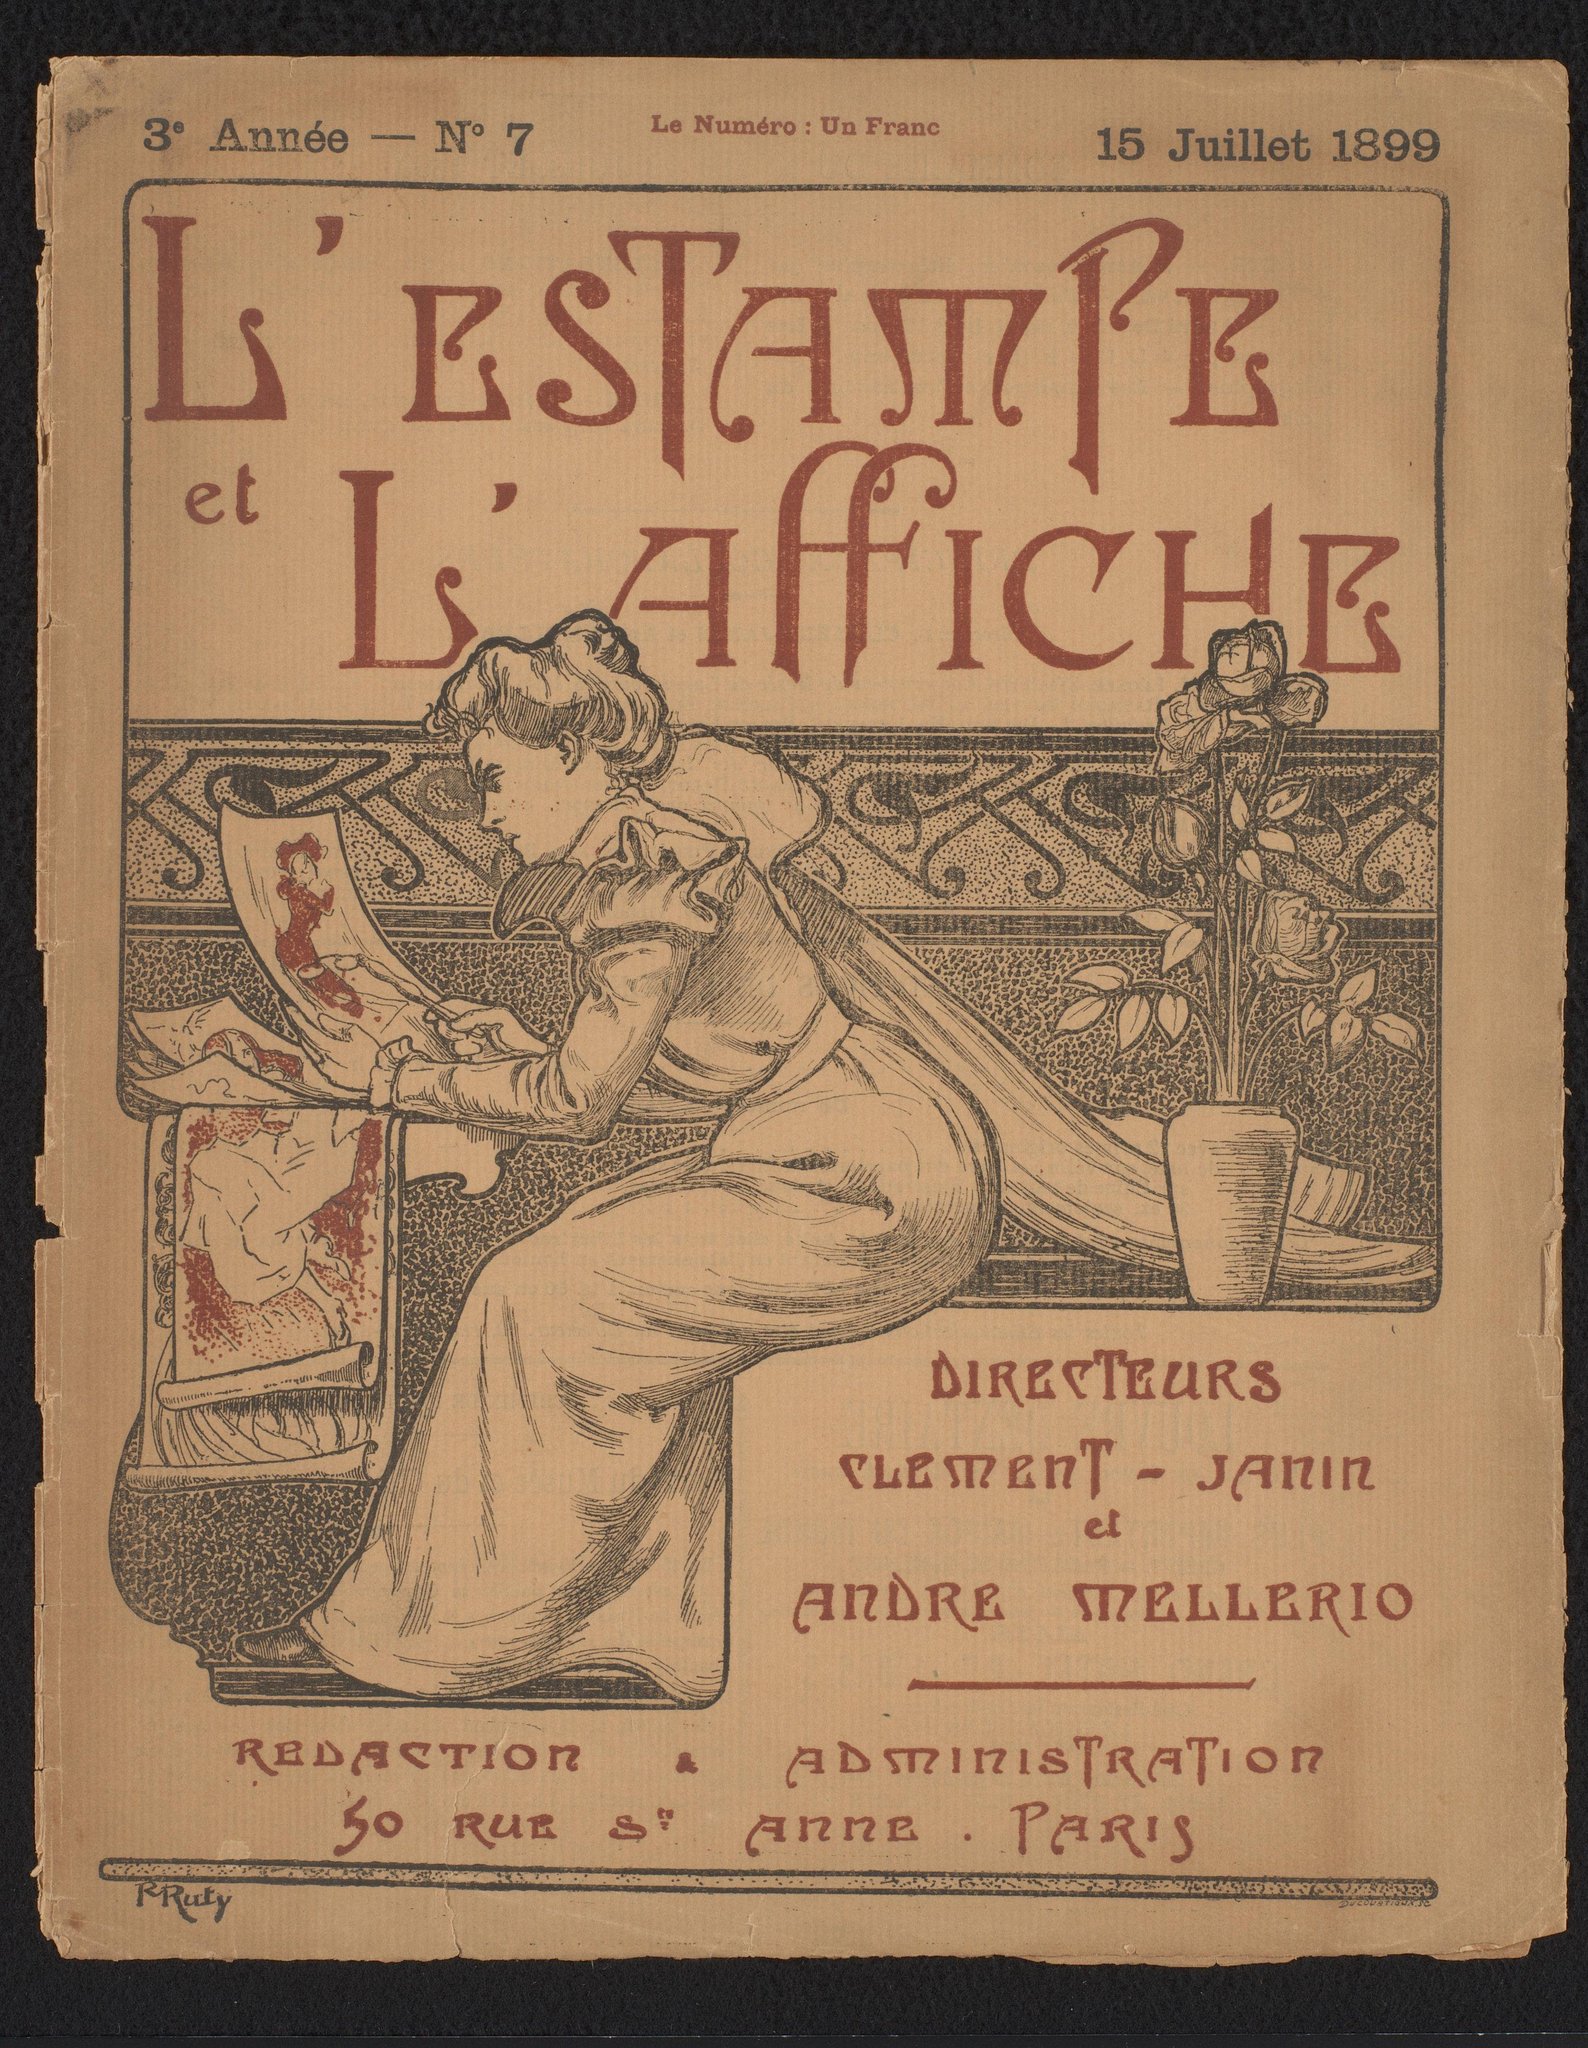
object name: wrapper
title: Omslag voor: L'estampe et l'affiche 3 (1899), nr. 7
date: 1899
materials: paper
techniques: letterpress printing, lithograph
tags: weekly, monthly, magazine, etc., print, e.g.: engraving, etching, lithograph, art collecting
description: Een zittende vrouw bekijkt prenten, in haar hand een lorgnet.